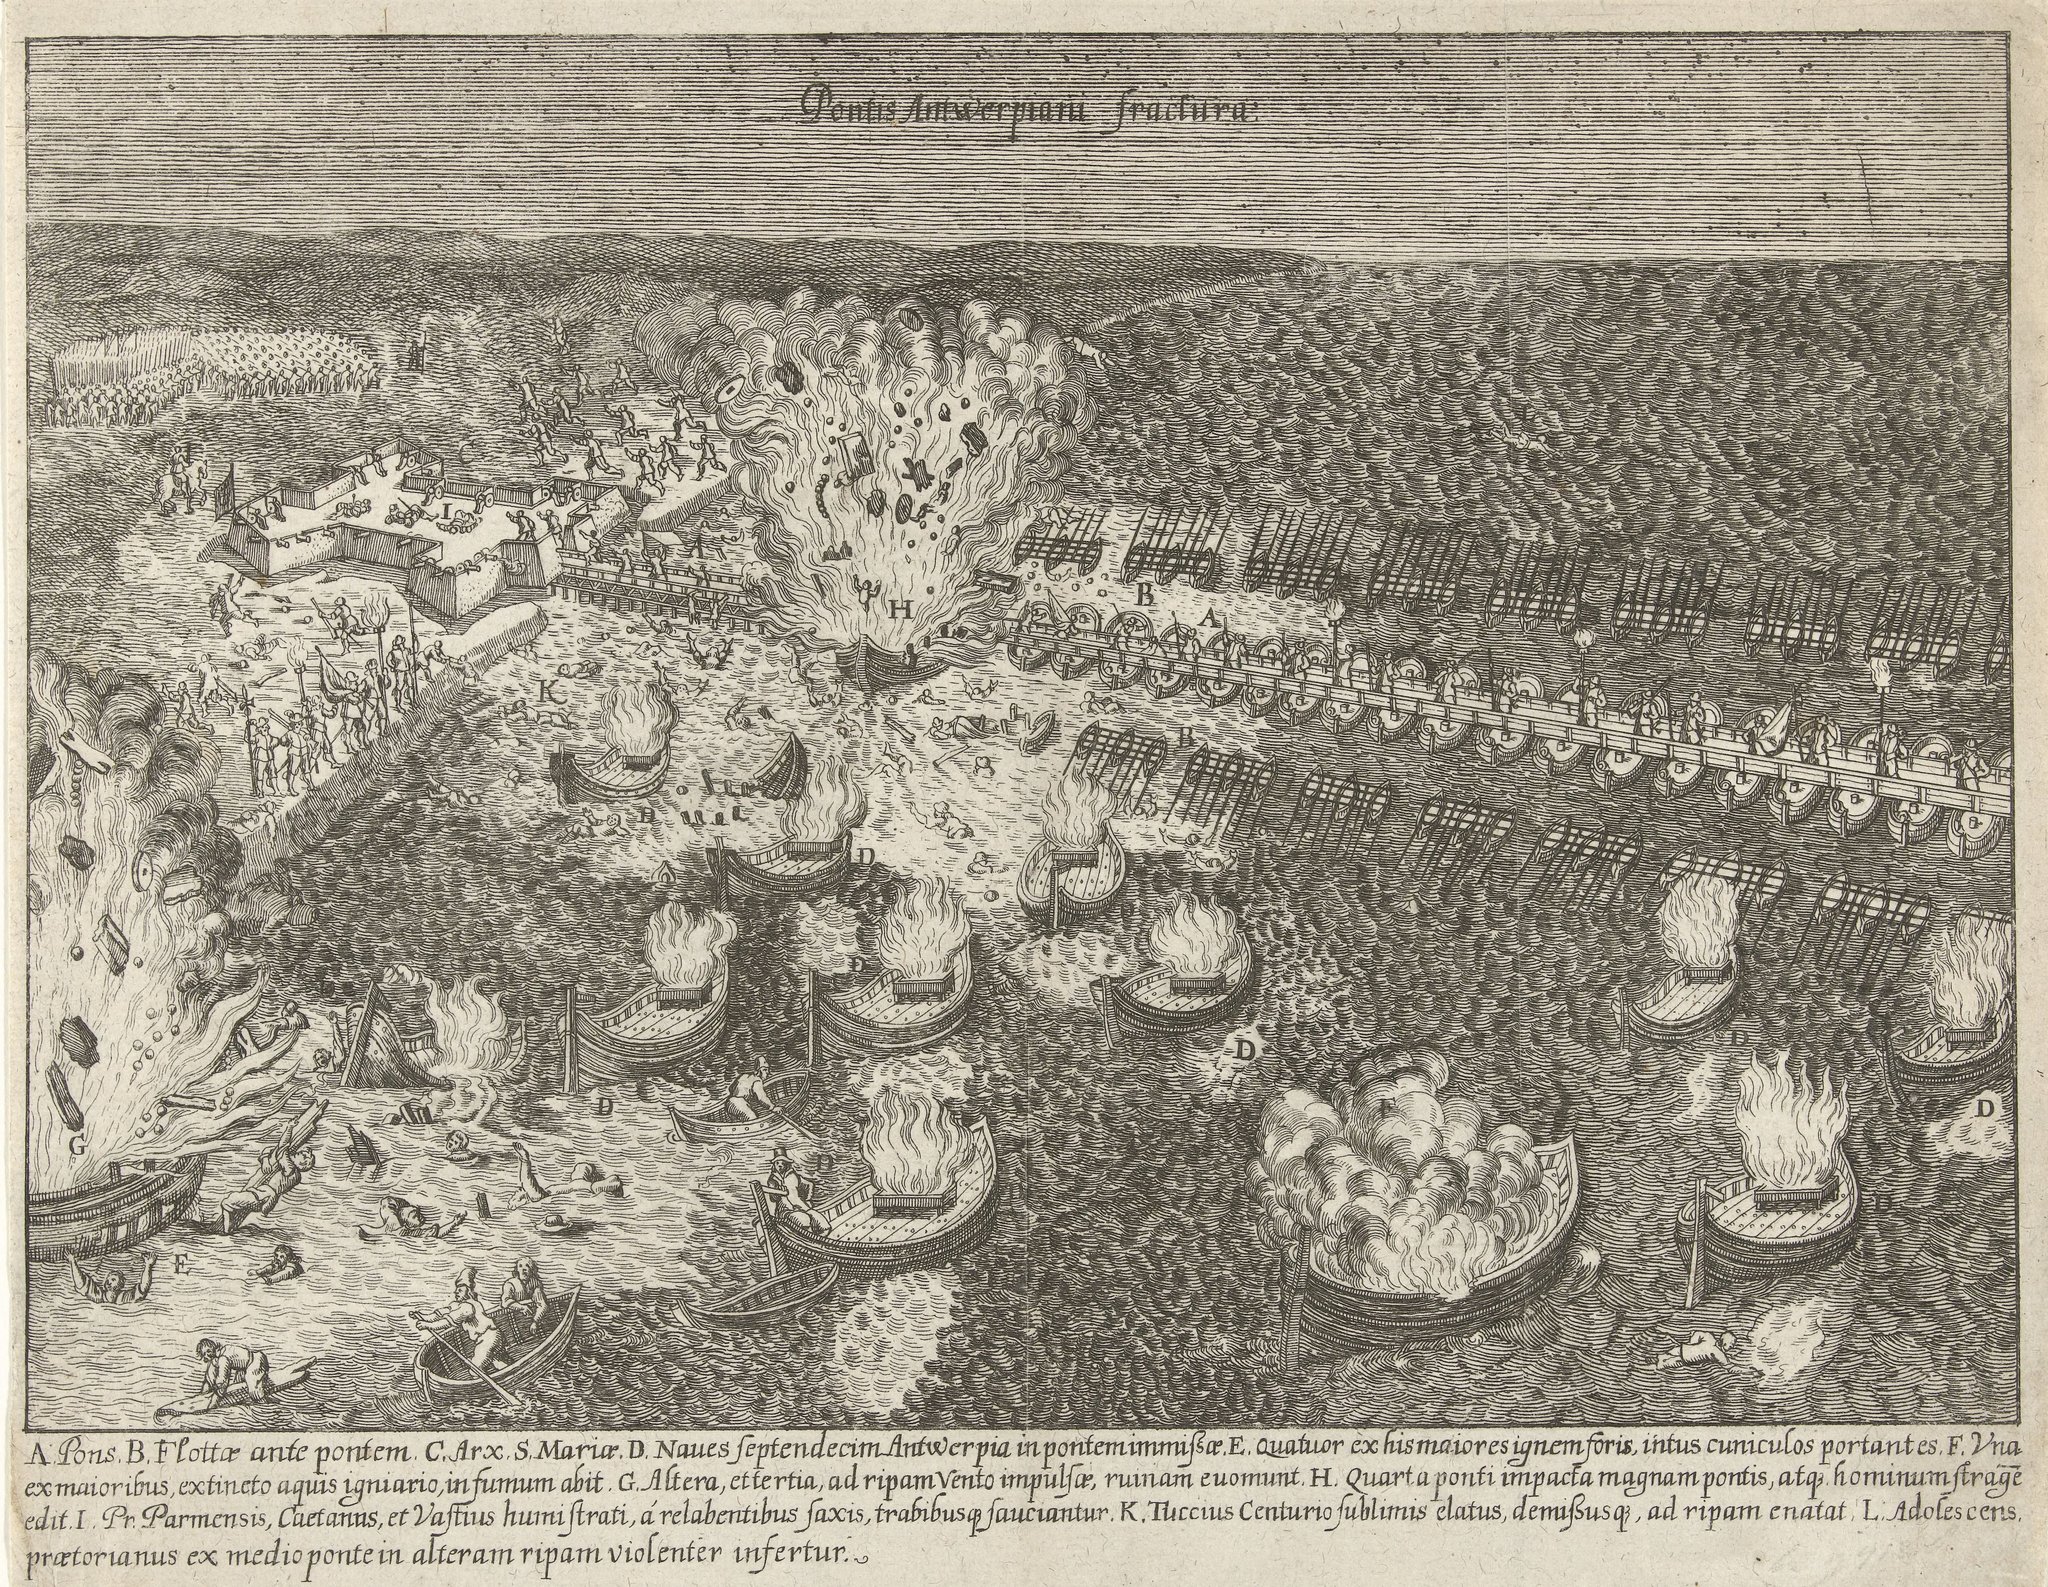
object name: history print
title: De schipbrug in de Schelde, 1585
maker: Anonymous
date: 1649-1651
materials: paper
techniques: etching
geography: rome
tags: rome, alessandro farnese (landvoogd van de nederlanden en hertog van parma en piacenza), pontoon bridge, antwerp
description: Gebruikt als illustratie in: F. Strada, De Bello belgico decades duae auctiores et correctiores cum figuris encis prodeunt a Famiano Strada Soc: Jesu Romano Moguntiae 1651. Kopie naar de anonieme prent in de oorspronkelijke editie van 1647, zie FMH 454A/19 en FMH 906.